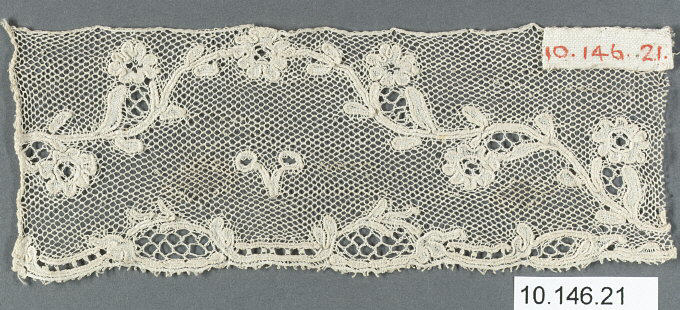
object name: fragment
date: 1701-1800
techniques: lace